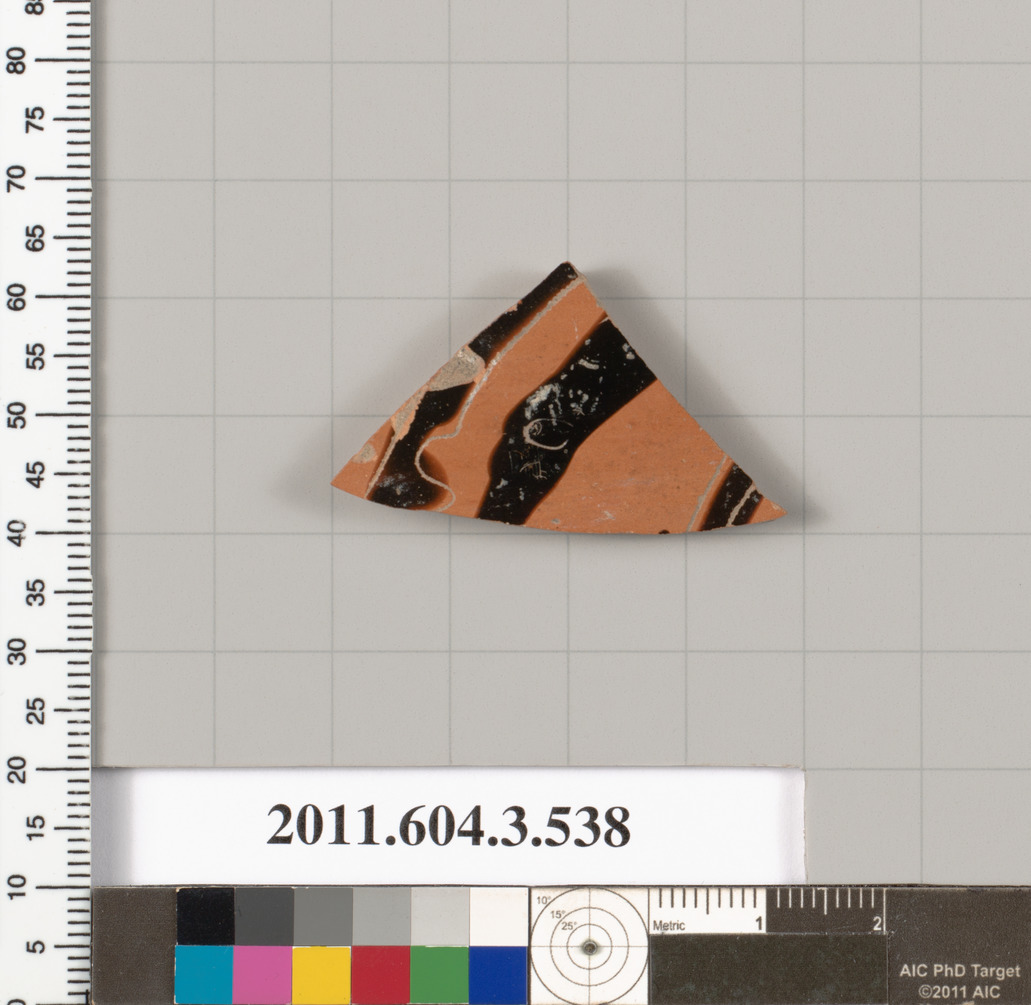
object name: column krater fragment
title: Terracotta fragment of a column-krater (bowl for mixing wine and water)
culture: greek, attic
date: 534-468 BCE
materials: terracotta